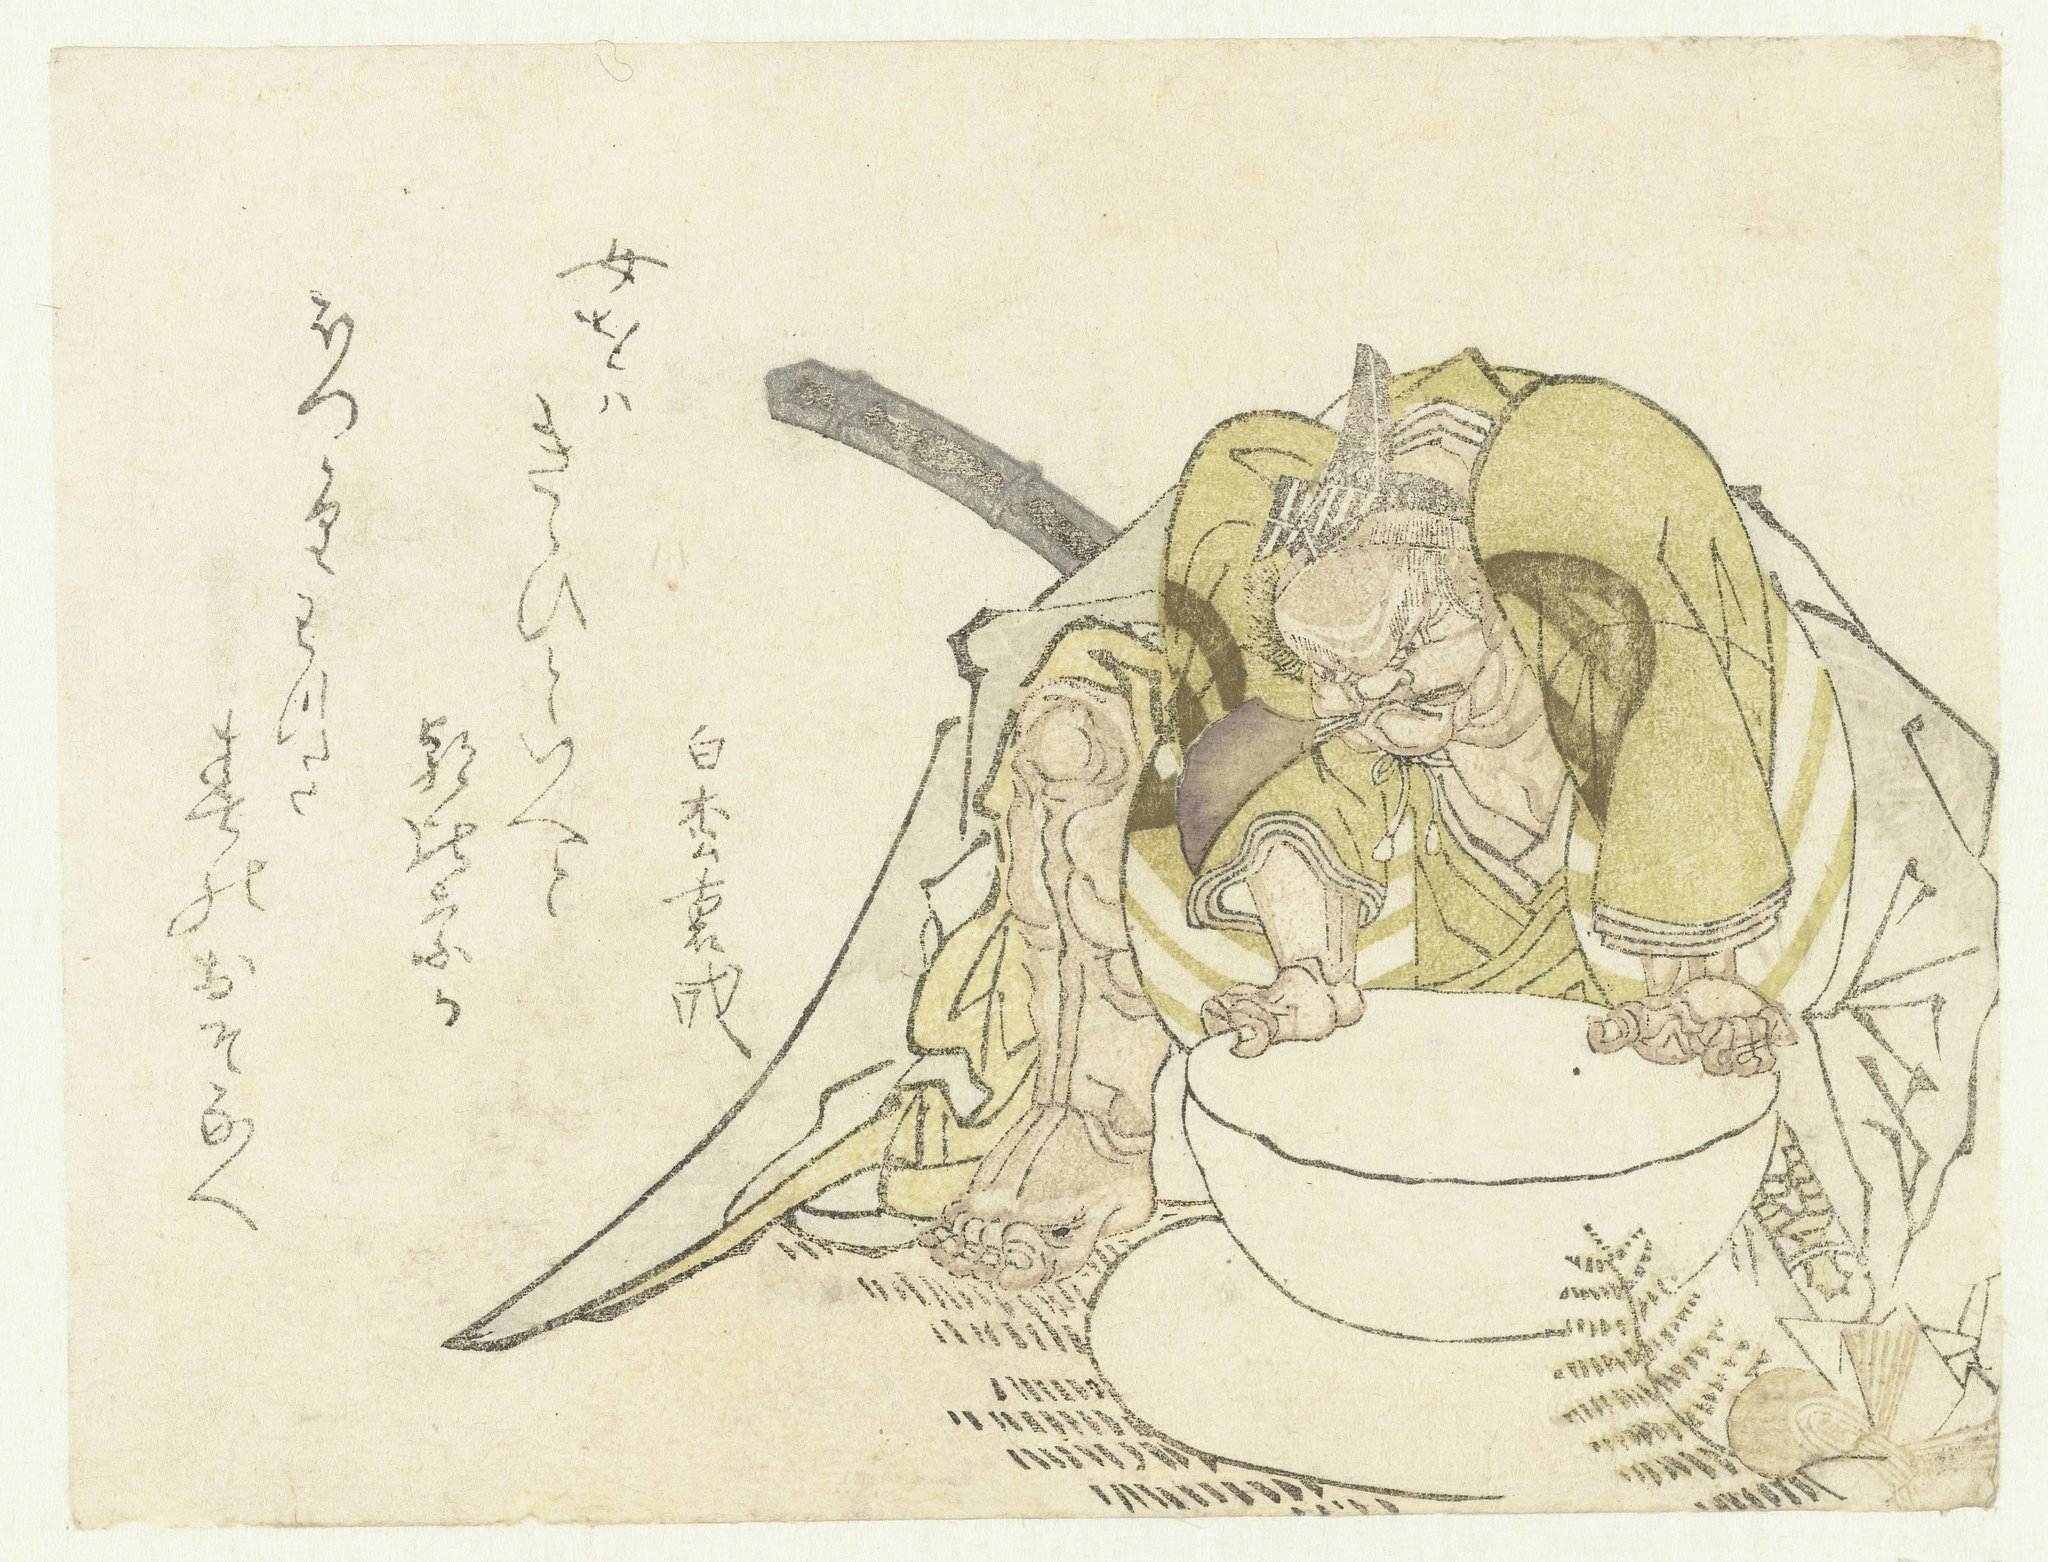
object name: surimono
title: Asashina Saburô probeert een rijstkoek te breken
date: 1790-1800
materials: paper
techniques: woodcut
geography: japan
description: Een surimono is een luxe uitgevoerde prent waarop beeld met één of meerdere gedichten gecombineerd is. Bij het drukken van een surimono werd vaak gebruik gemaakt van dikker papier, blinddruk en metaal pigmenten, zoals koper- en zilverpoeder. De prenten werden vaak in opdracht van dichters gemaakt en als exclusief geschenk aan vrienden en relaties gegeven.